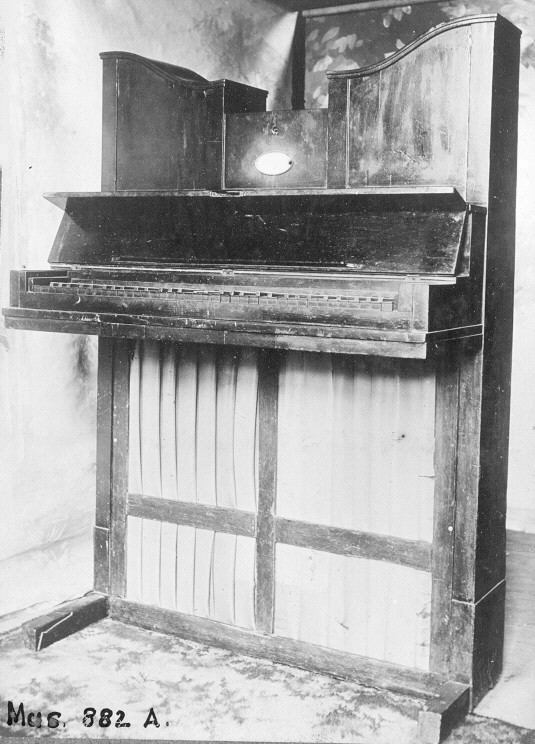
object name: upright piano ditanaklasis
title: Upright Piano (Ditanaklasis)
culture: austrian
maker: matthias müller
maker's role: maker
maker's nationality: german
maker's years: 1770-1840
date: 1800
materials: wood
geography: austria